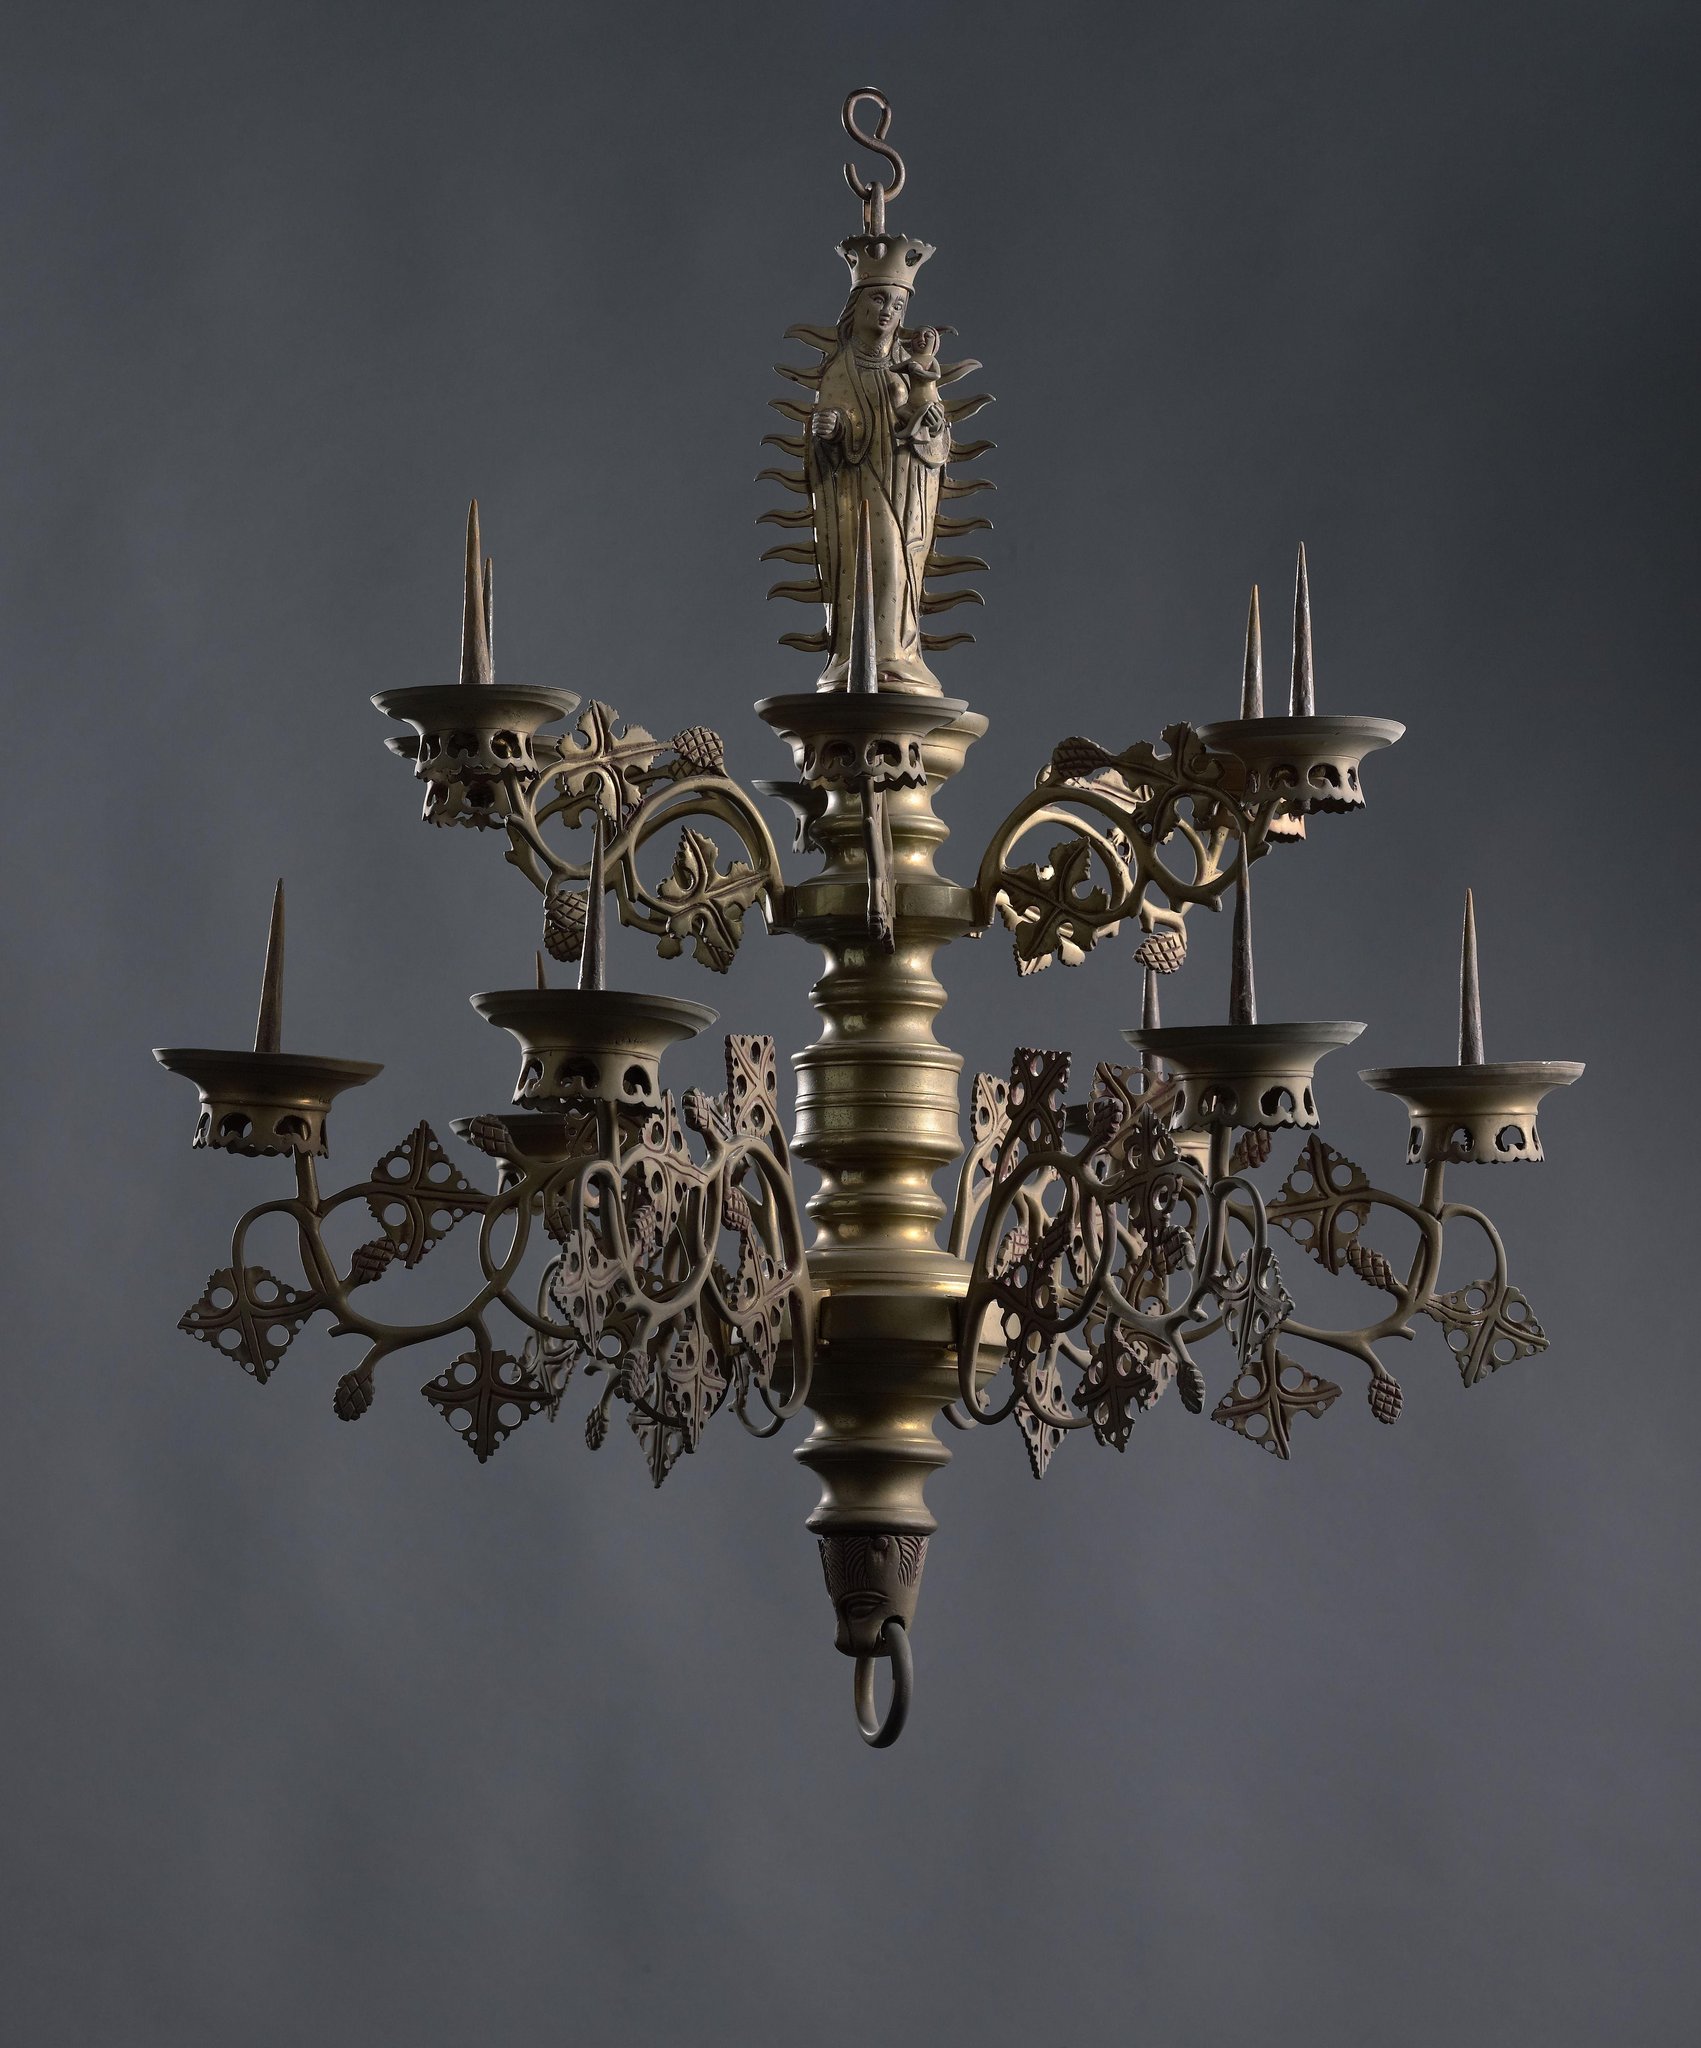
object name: chandelier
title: Arm met kaarsenhouder van kaarsenkroon van twee hoogten met ieder zes armen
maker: Anonymous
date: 1475-1500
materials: brass, iron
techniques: casting, metalworking, forging, screwed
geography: southern netherlands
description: Kaarsenarm behorende bij een kaarsenkroon van twee hoogten met Mariafiguur bovenaan. De arm is twee maal gebogen en is versierd met vier druiventrossen en vijf wingerdbladeren. De ronde vetvanger heeft aan de onderkant opengewerkte, gekartelde verticaal geplaatste randen, ter maskering van de bevestiging op de arm. Dit geschiedt door een ronde ijzeren pin, die in het einde van de arm is geschroefd. Dit is de vijfde arm van de onderste ring, genummerd met 5 verticale inkepingen. De vetvanger is genummerd met V-vormige inkeping.